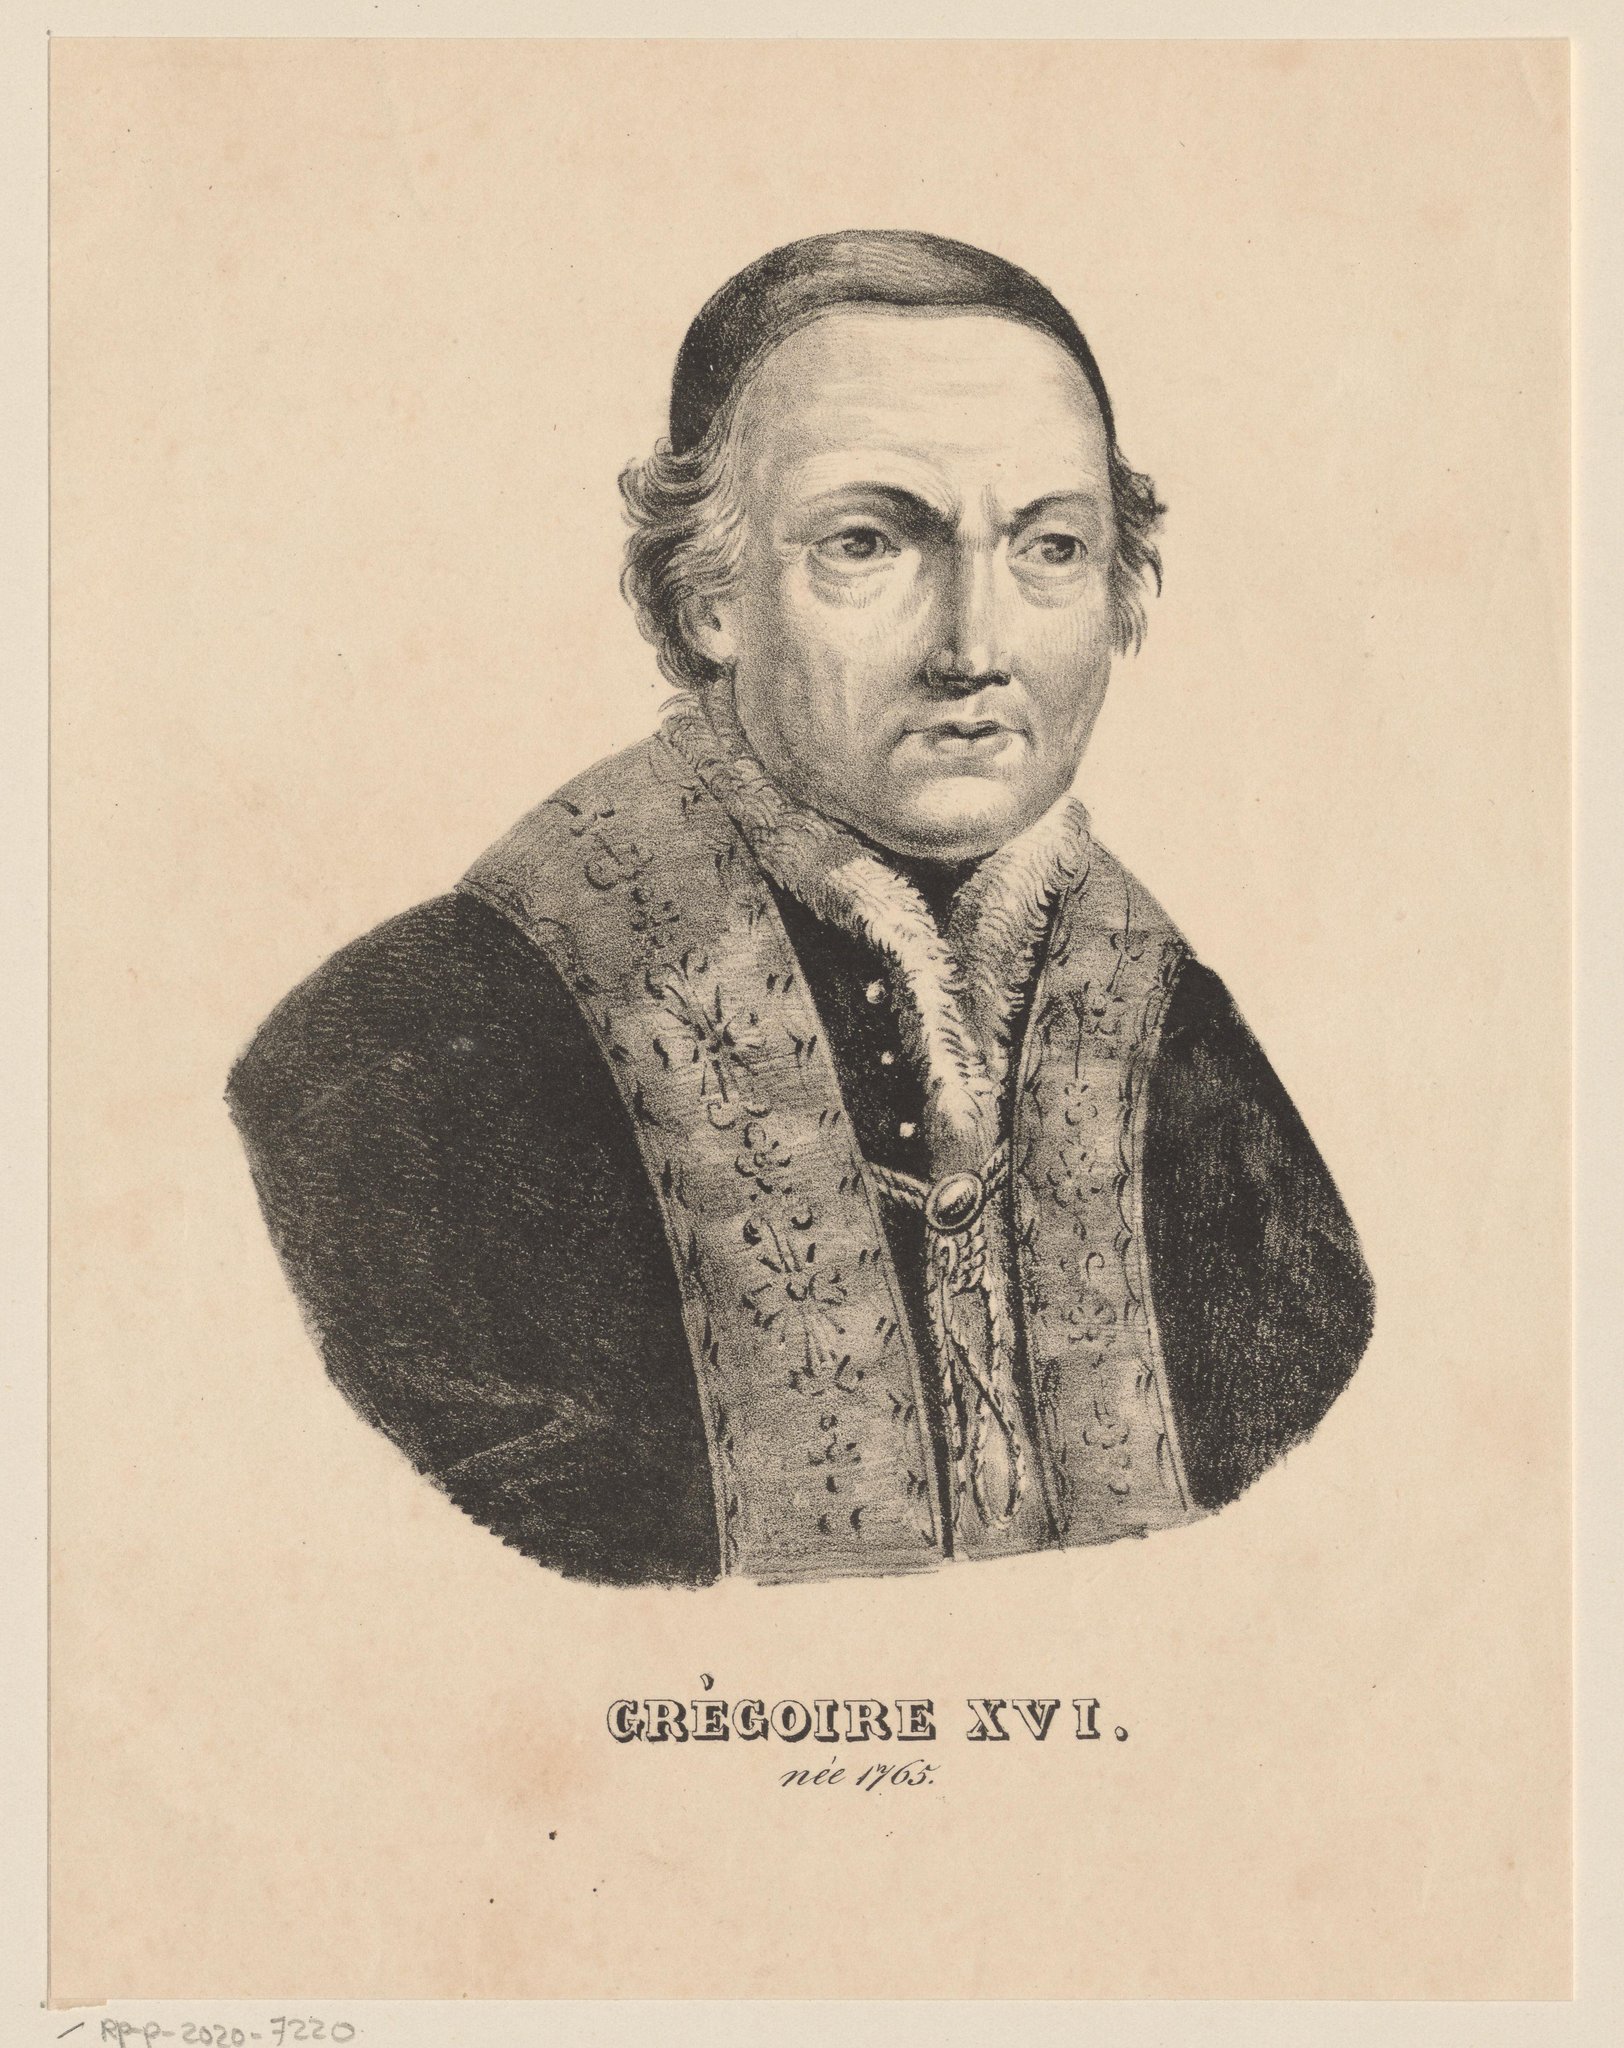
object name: print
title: Portret van paus Gregorius XVI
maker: Anonymous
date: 1800-1831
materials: paper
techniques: lithograph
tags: rome, historical persons, pope